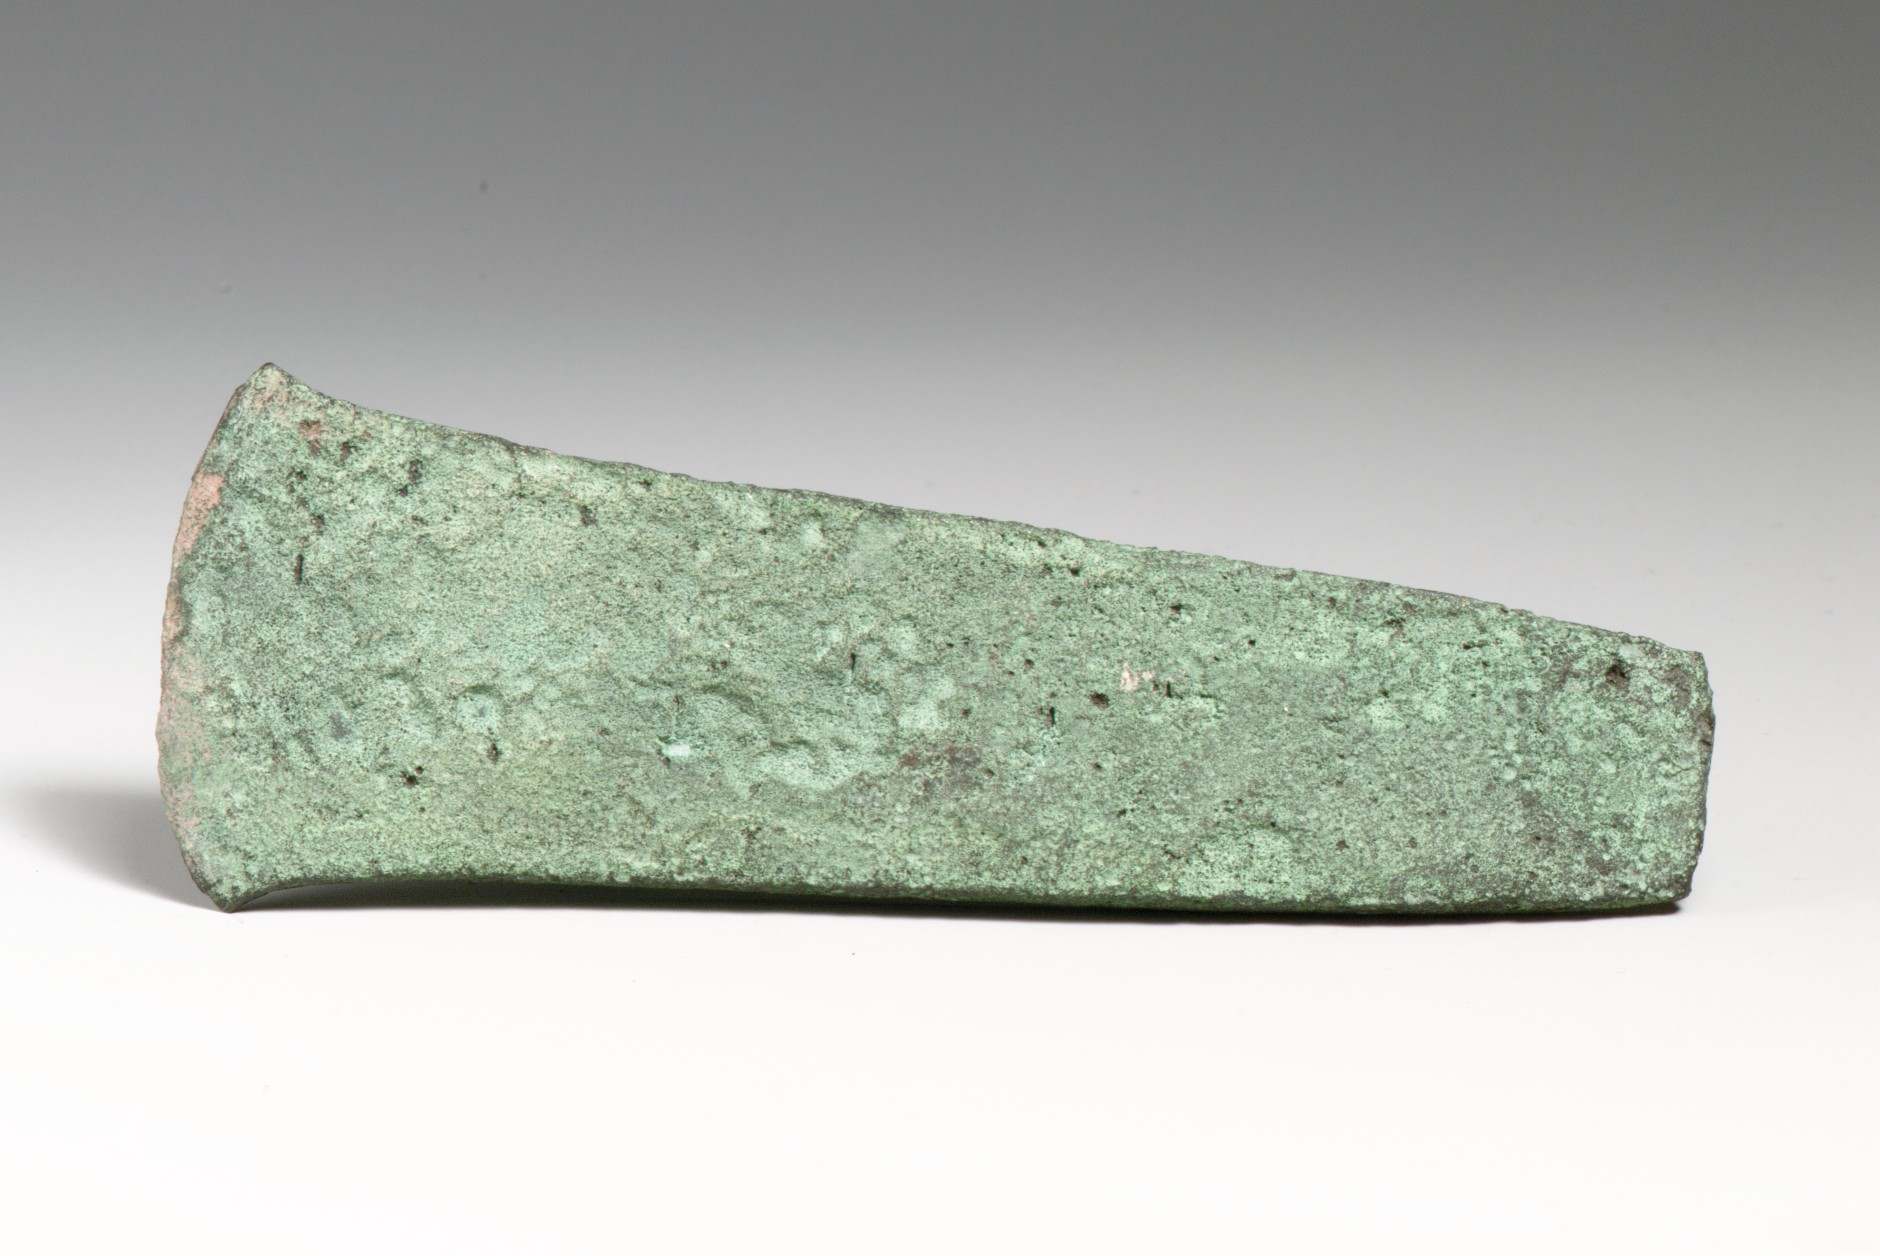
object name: axehead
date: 7000 BCE-330 CE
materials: bronze